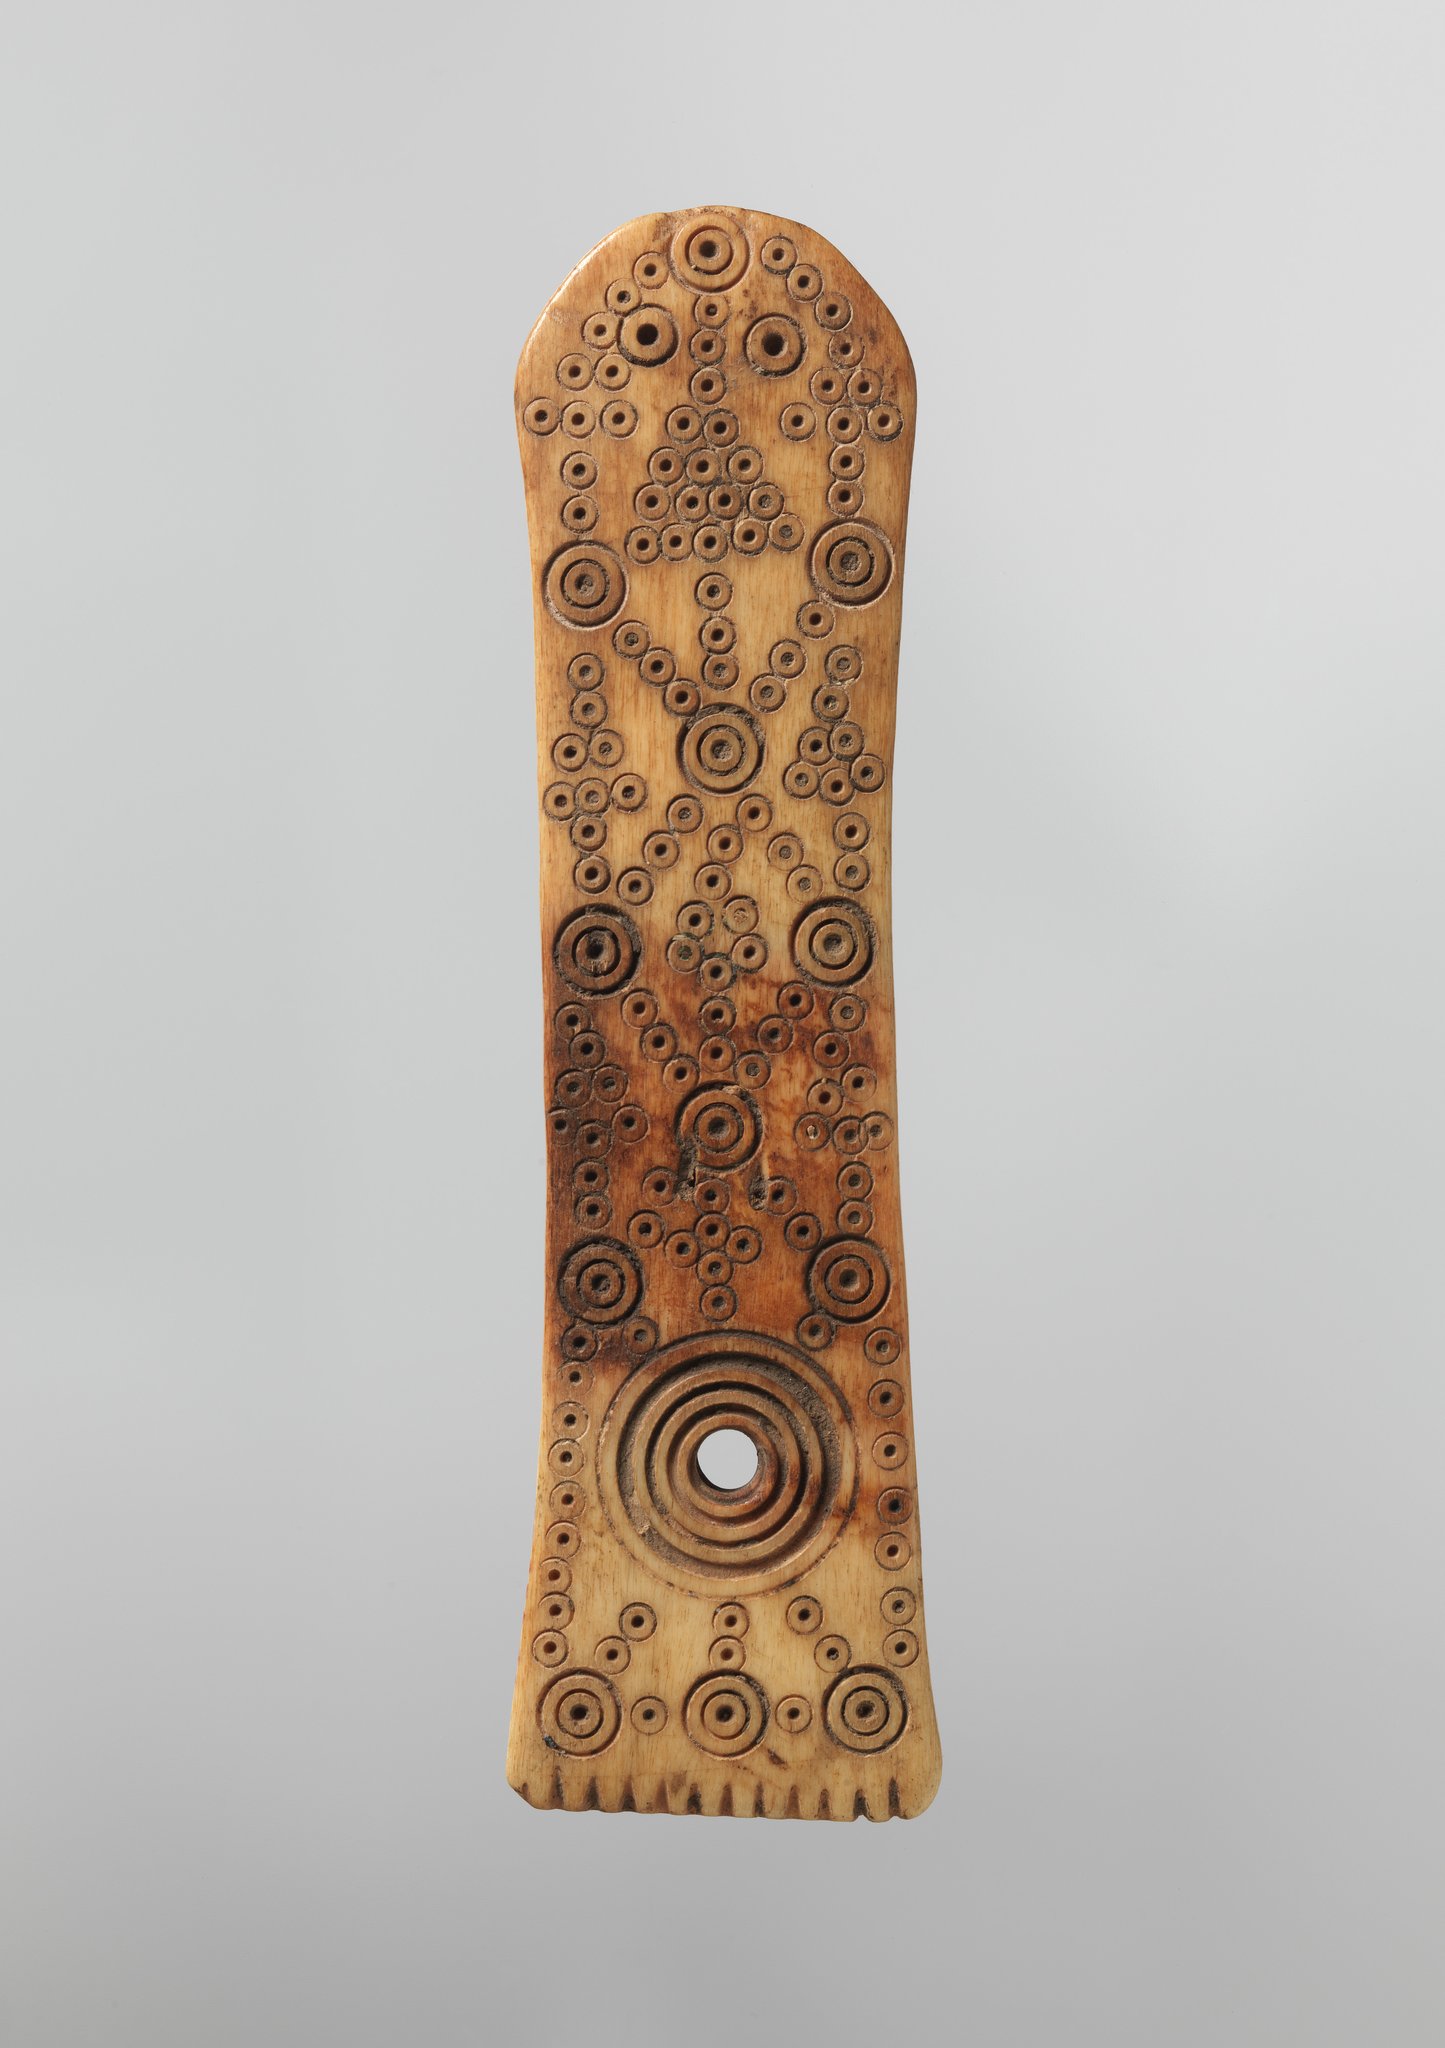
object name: peg for a bookbinding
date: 401-700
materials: bone, paint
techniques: incising, inlay, tinting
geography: egypt